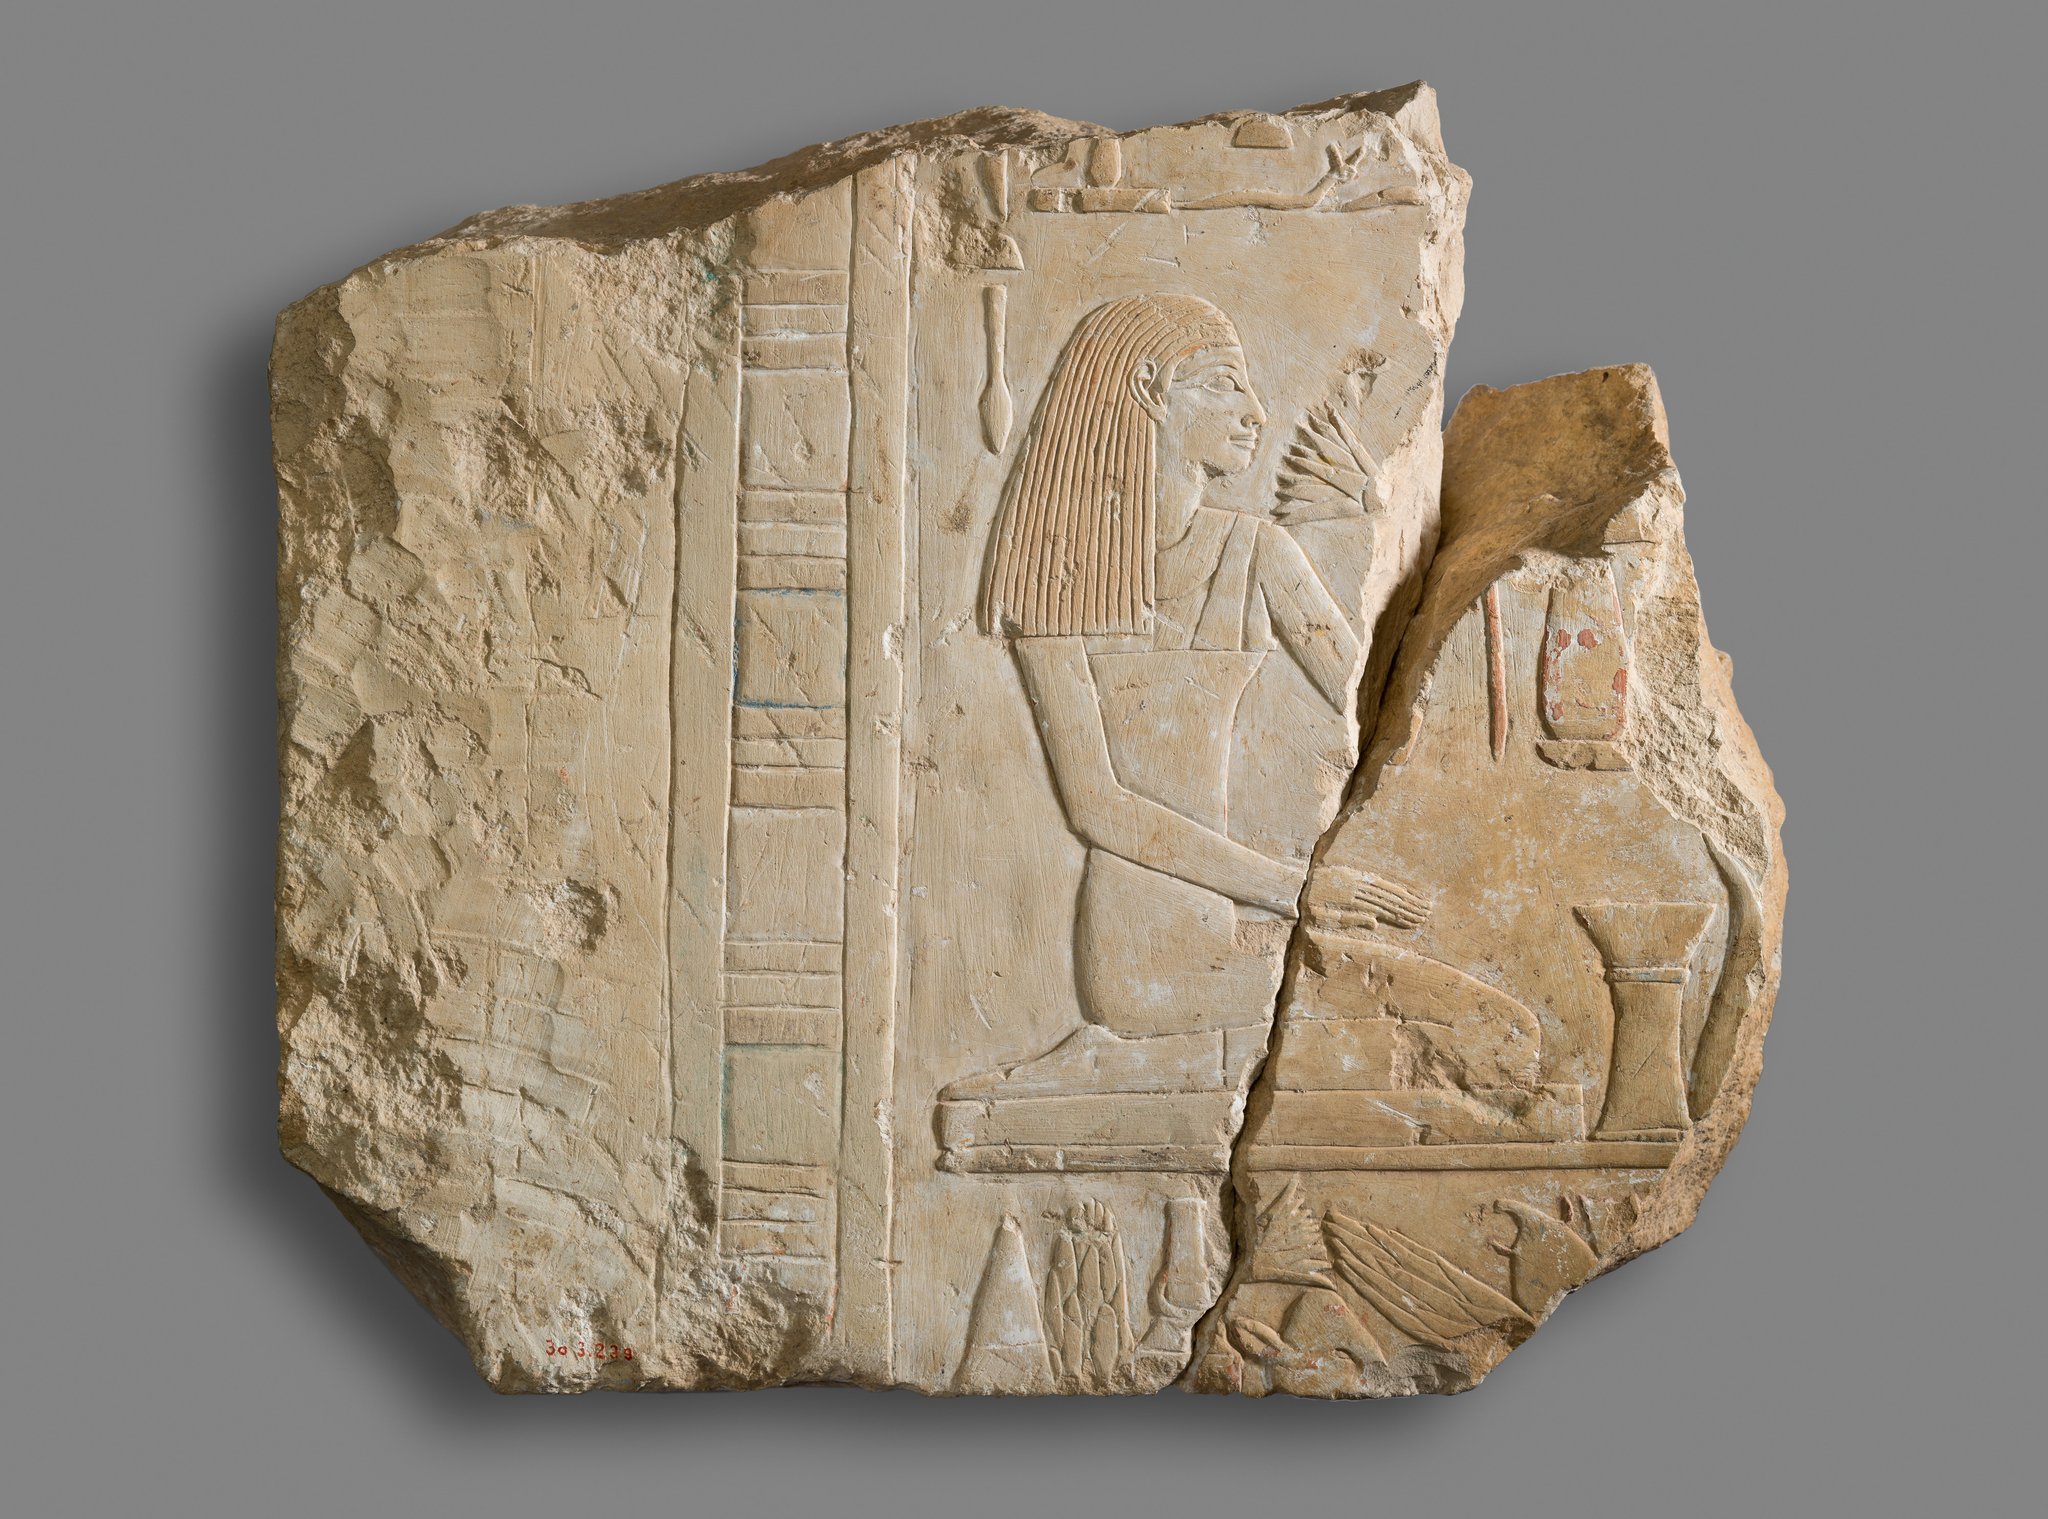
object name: relief, kneeling woman, senenmut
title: Relief Fragment Depicting a Kneeling Woman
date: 1479-1458 BCE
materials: limestone, paint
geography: egypt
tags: women